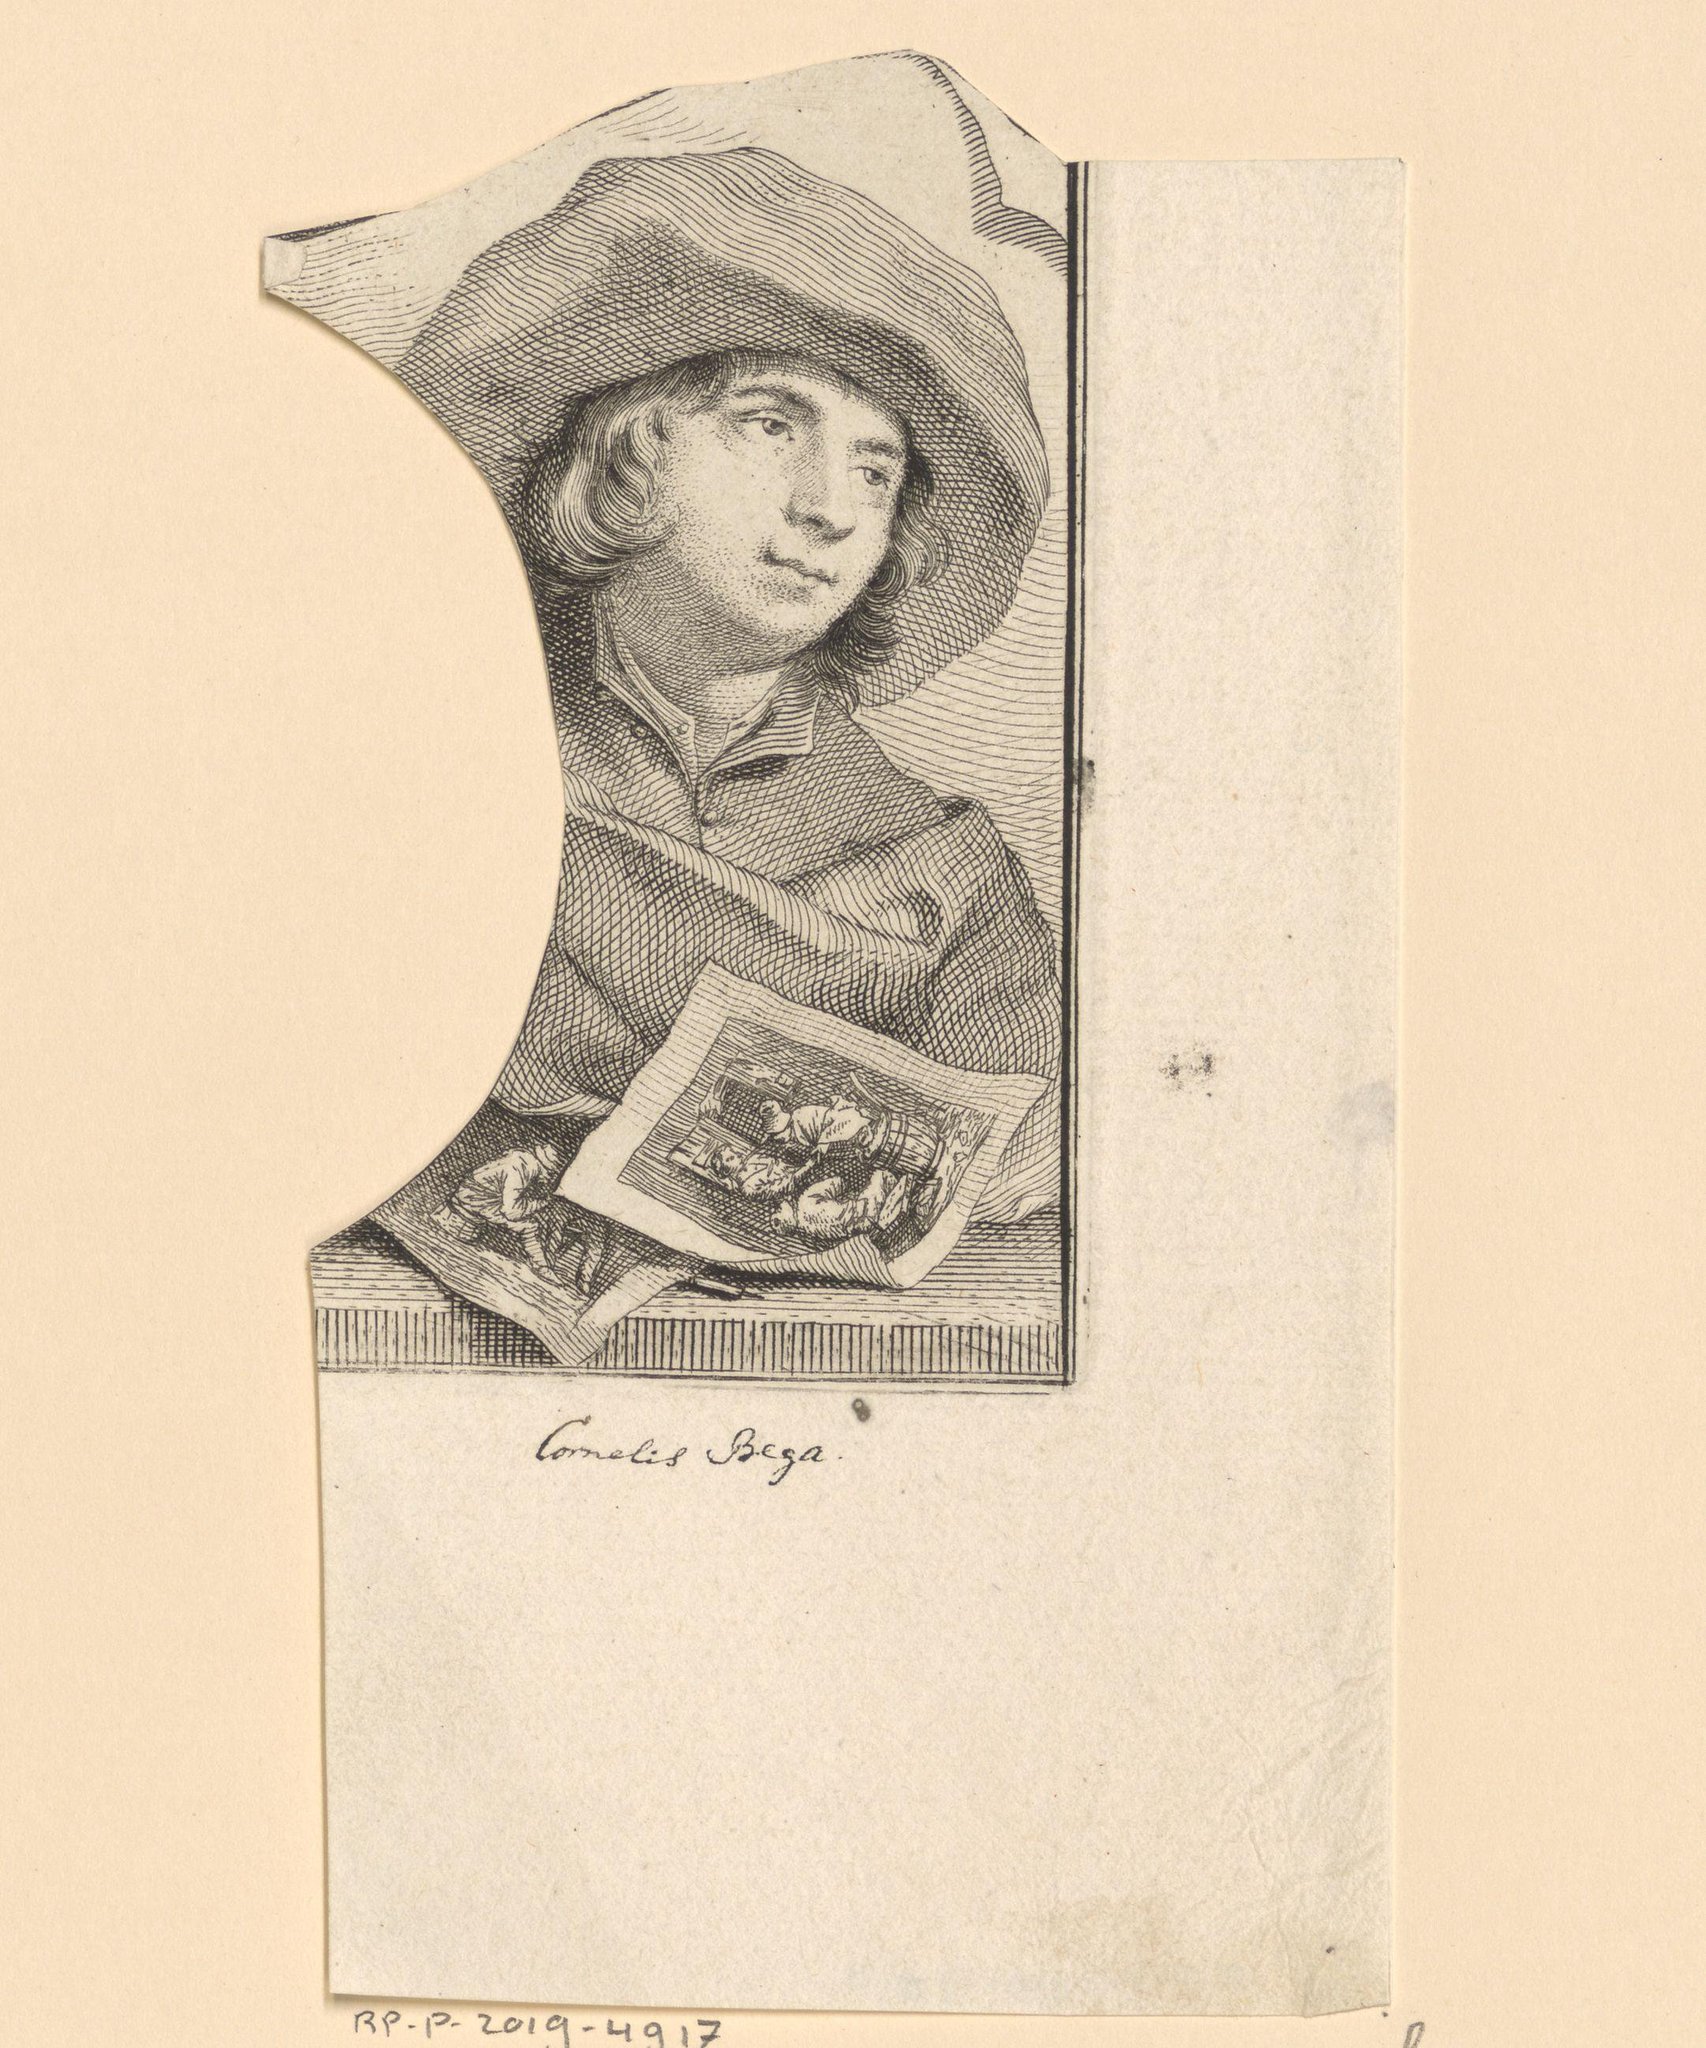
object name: print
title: Portret van Cornelis Pietersz. Bega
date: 1718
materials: paper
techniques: engraving, etching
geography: amsterdam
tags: haarlem, cornelis pietersz. bega, historical persons, portrait, self-portrait of painter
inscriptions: inscription: ‘Cornelis Bega’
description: Prent uit: Houbraken, Arnold. De groote schouburgh der Nederlantsche konstschilders en schilderessen (...). Amsterdam: Arnold Houbraken, 1718, dl. 1.